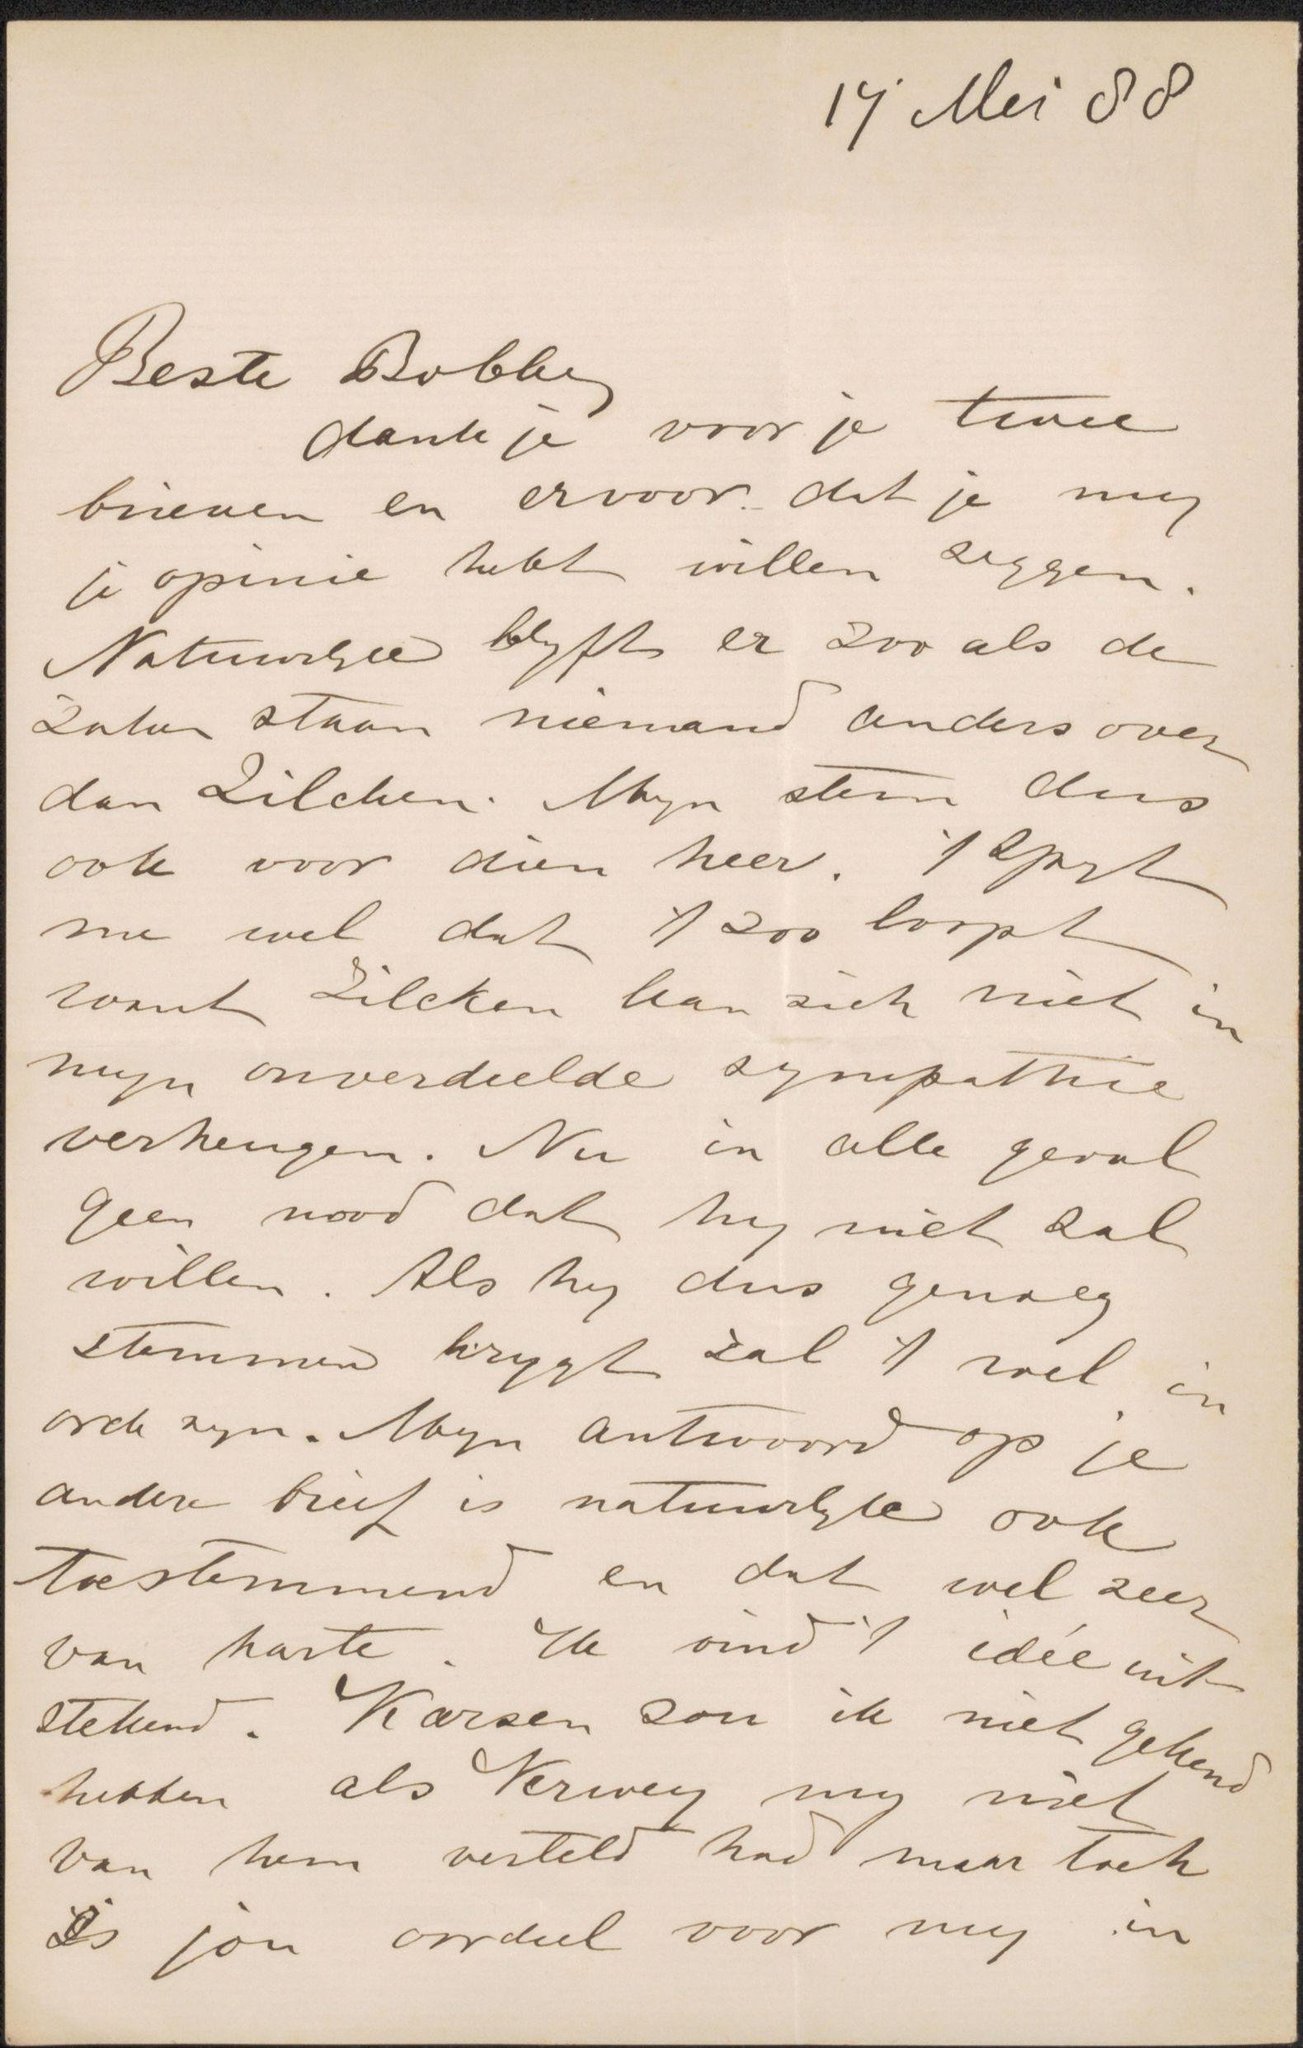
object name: letter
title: Brief aan Jan Veth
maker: wally moes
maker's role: draughtsman, print maker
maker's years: 1856-1918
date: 1874-1918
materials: ink, paper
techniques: pen, writing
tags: rotterdam, george hendrik breitner, dordrecht, designer, jan veth, london, matthijs maris, jacob maris, amsterdam, painter, print maker, draughtsman, eduard karsen, albert verwey, philip zilcken, workshop, studio of the artist (in general), exhibition ~ art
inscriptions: collector's mark: ‘RPK’